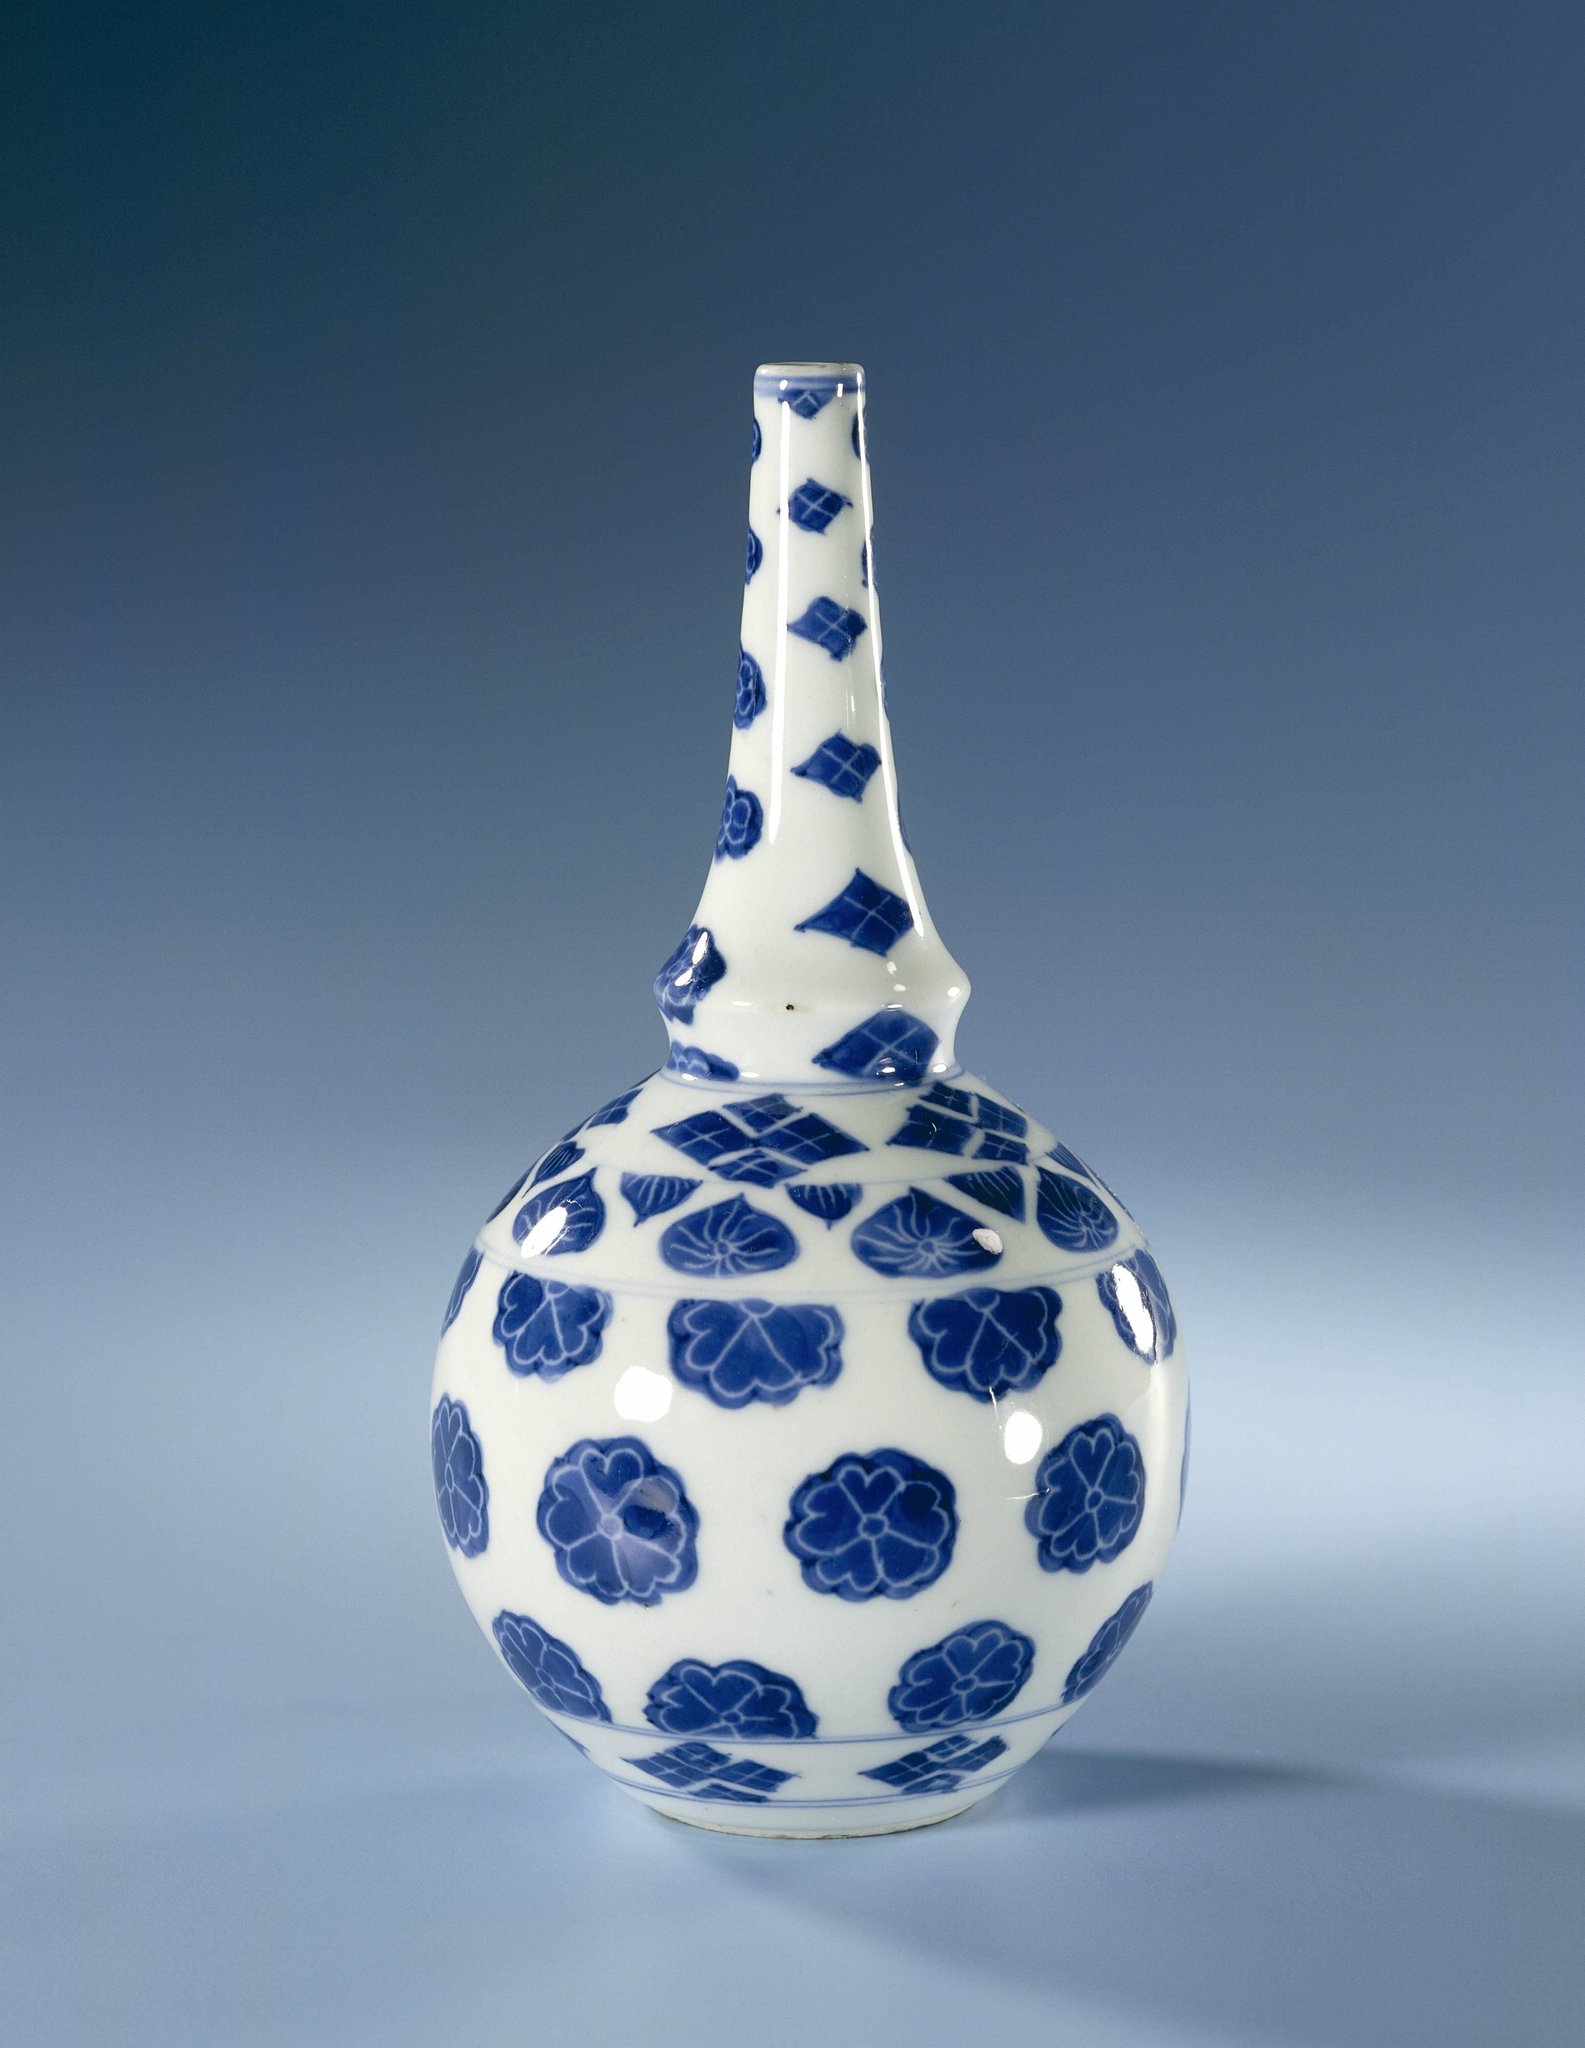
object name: sprinkler flask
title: Rosewater sprinkler or bottle with roundels and lozenges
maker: Anonymous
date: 1700-1724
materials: cobalt, glaze, paint, porcelain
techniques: firing, turning, vitrification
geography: china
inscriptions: mark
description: AK-NM-6742 Rozenwaterdruppelaar • Blauw-wit Kangxi-porselein • Onderdeel van Royers porseleincollectie • Oorspronkelijk twee exemplaren (inventaris Van der Kellen 1876) • Gepubliceerd: Jörg 1997, nr. 104 Voor enige opmerkingen over rozenwaterdruppelaars, zie de toelichting bij AK-NM-6738. Identieke flesjes met dit atypische decor komen voor in de collecties van het Frans Hals Museum (een paar), Haarlem en het British Museum (Franks. 138). Bronnen: Christiaan J.A. Jörg, Chinese ceramics in the collection of the Rijksmuseum, Amsterdam: the Ming and Qing dynasties, Londen, 1997.